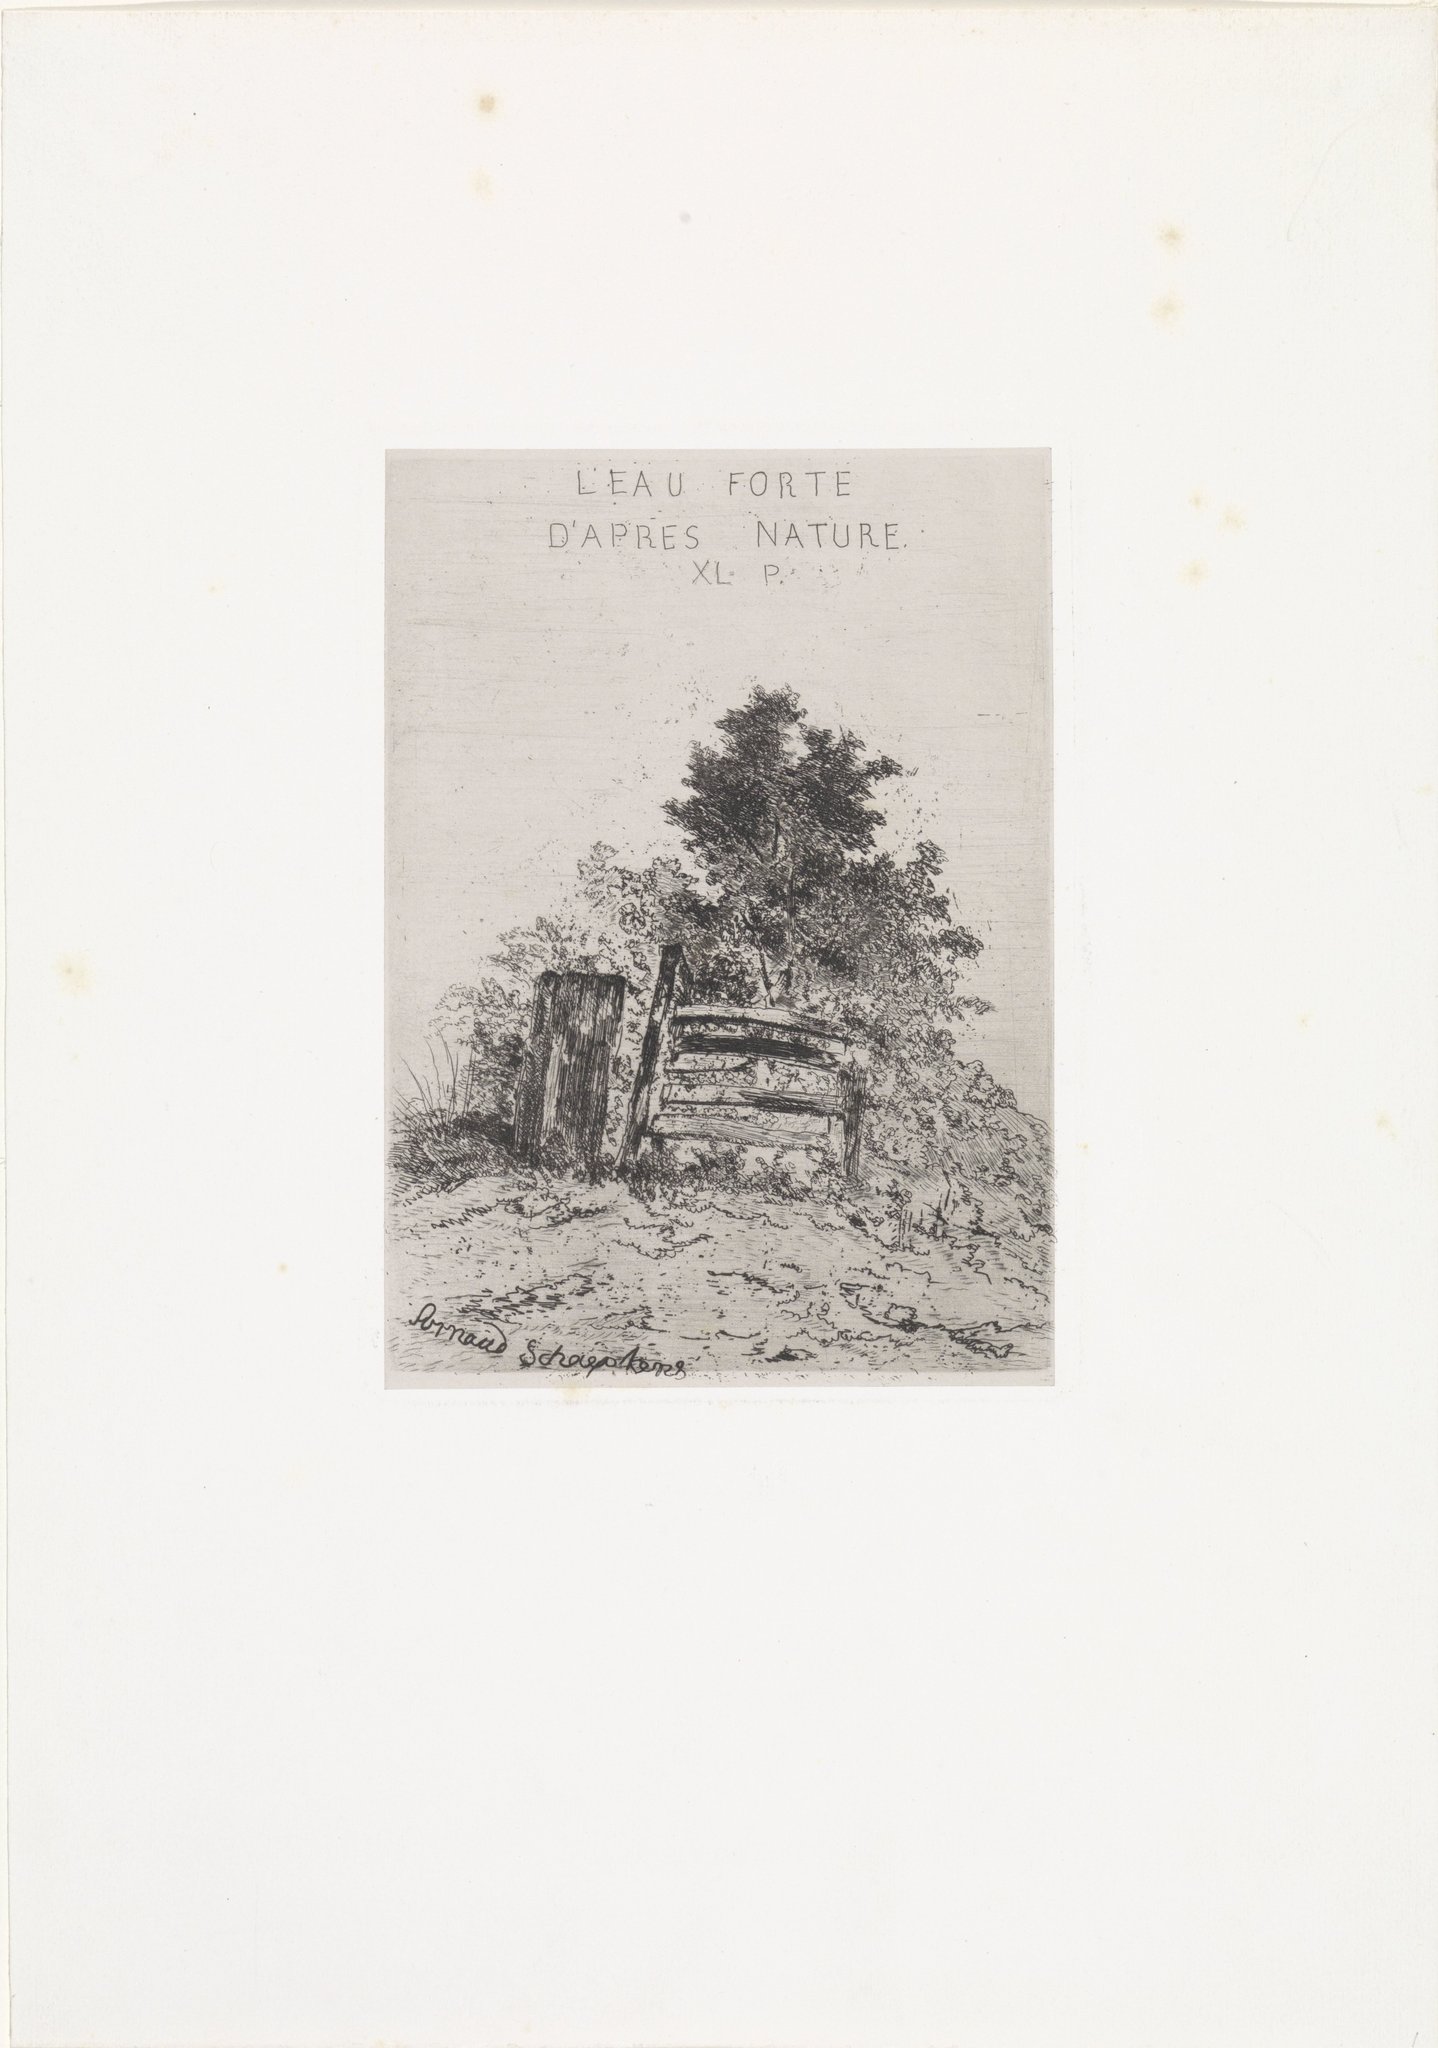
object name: print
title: L'eau forte d'apres nature XL P.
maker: arnoud schaepkens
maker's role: print maker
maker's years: 1816-1904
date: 1855-1904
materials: paper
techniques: drypoint, etching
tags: annexes and outbuildings; fencing; gate, landscapes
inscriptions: collector's mark: Lugt 2228